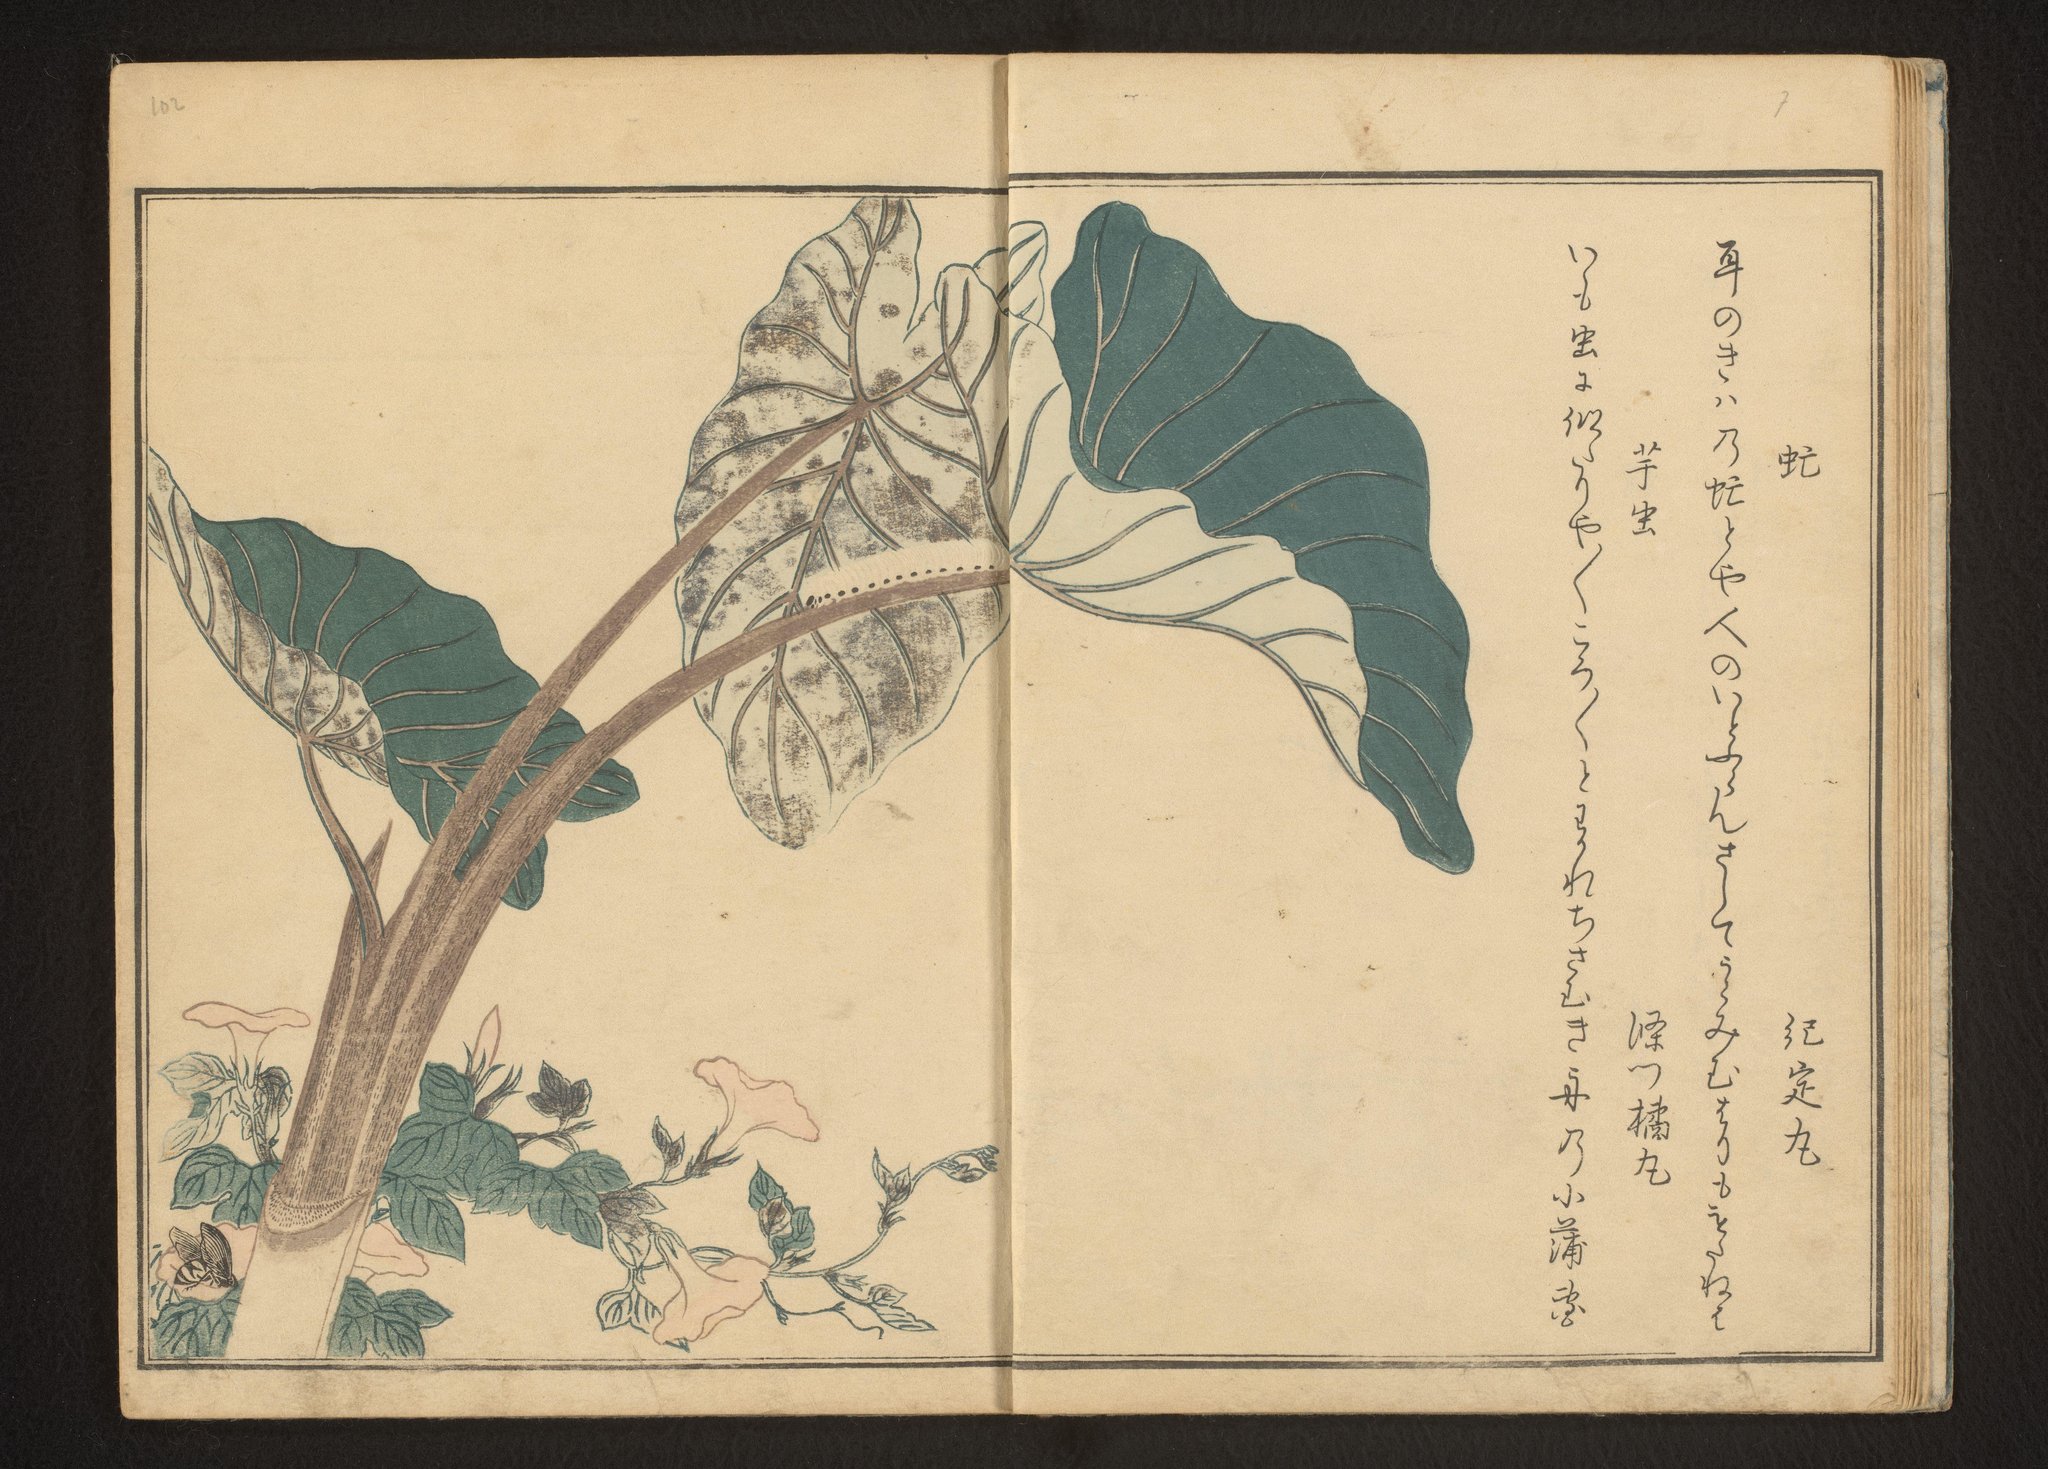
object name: page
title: Horsefly on bindweed and caterpillar on taro plant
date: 1788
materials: paper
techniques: blind stamped, woodcut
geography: edo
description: pagina 6b en 7a in deel één van het Insectenboek van Utamaro.